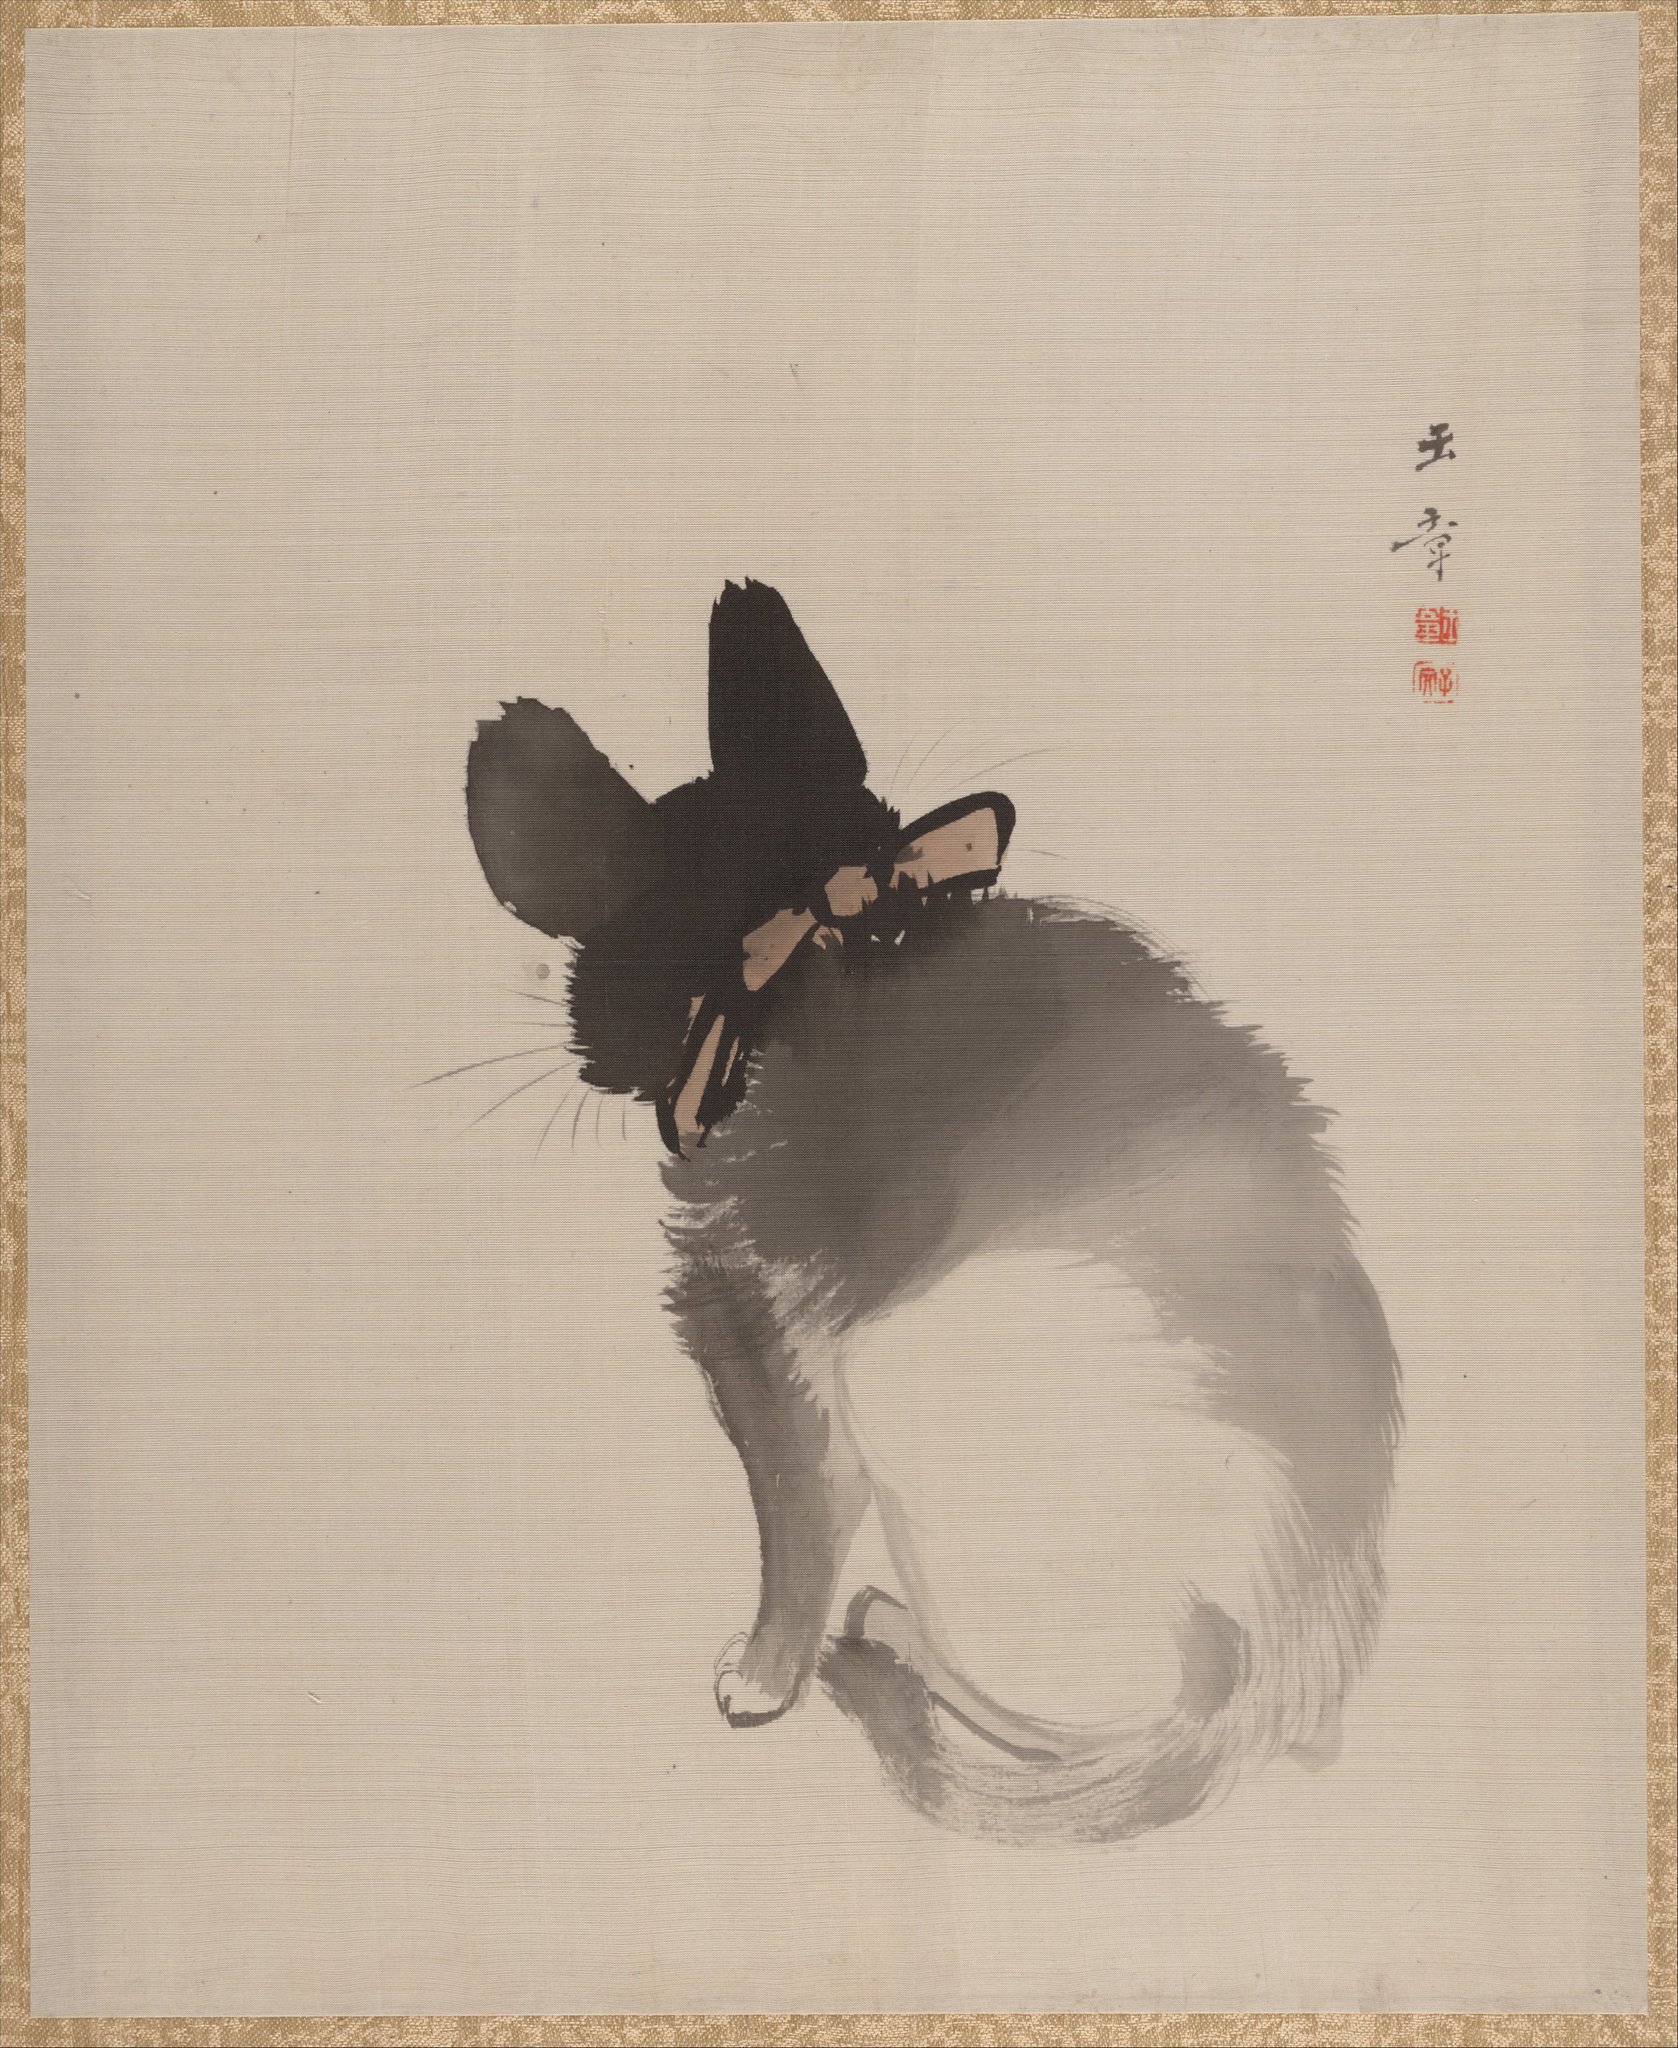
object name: album leaf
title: Cat Seen from Behind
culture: japanese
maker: kawabata gyokushō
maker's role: artist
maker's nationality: japanese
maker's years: 1842-1913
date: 1887-1892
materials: ink, silk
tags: cats